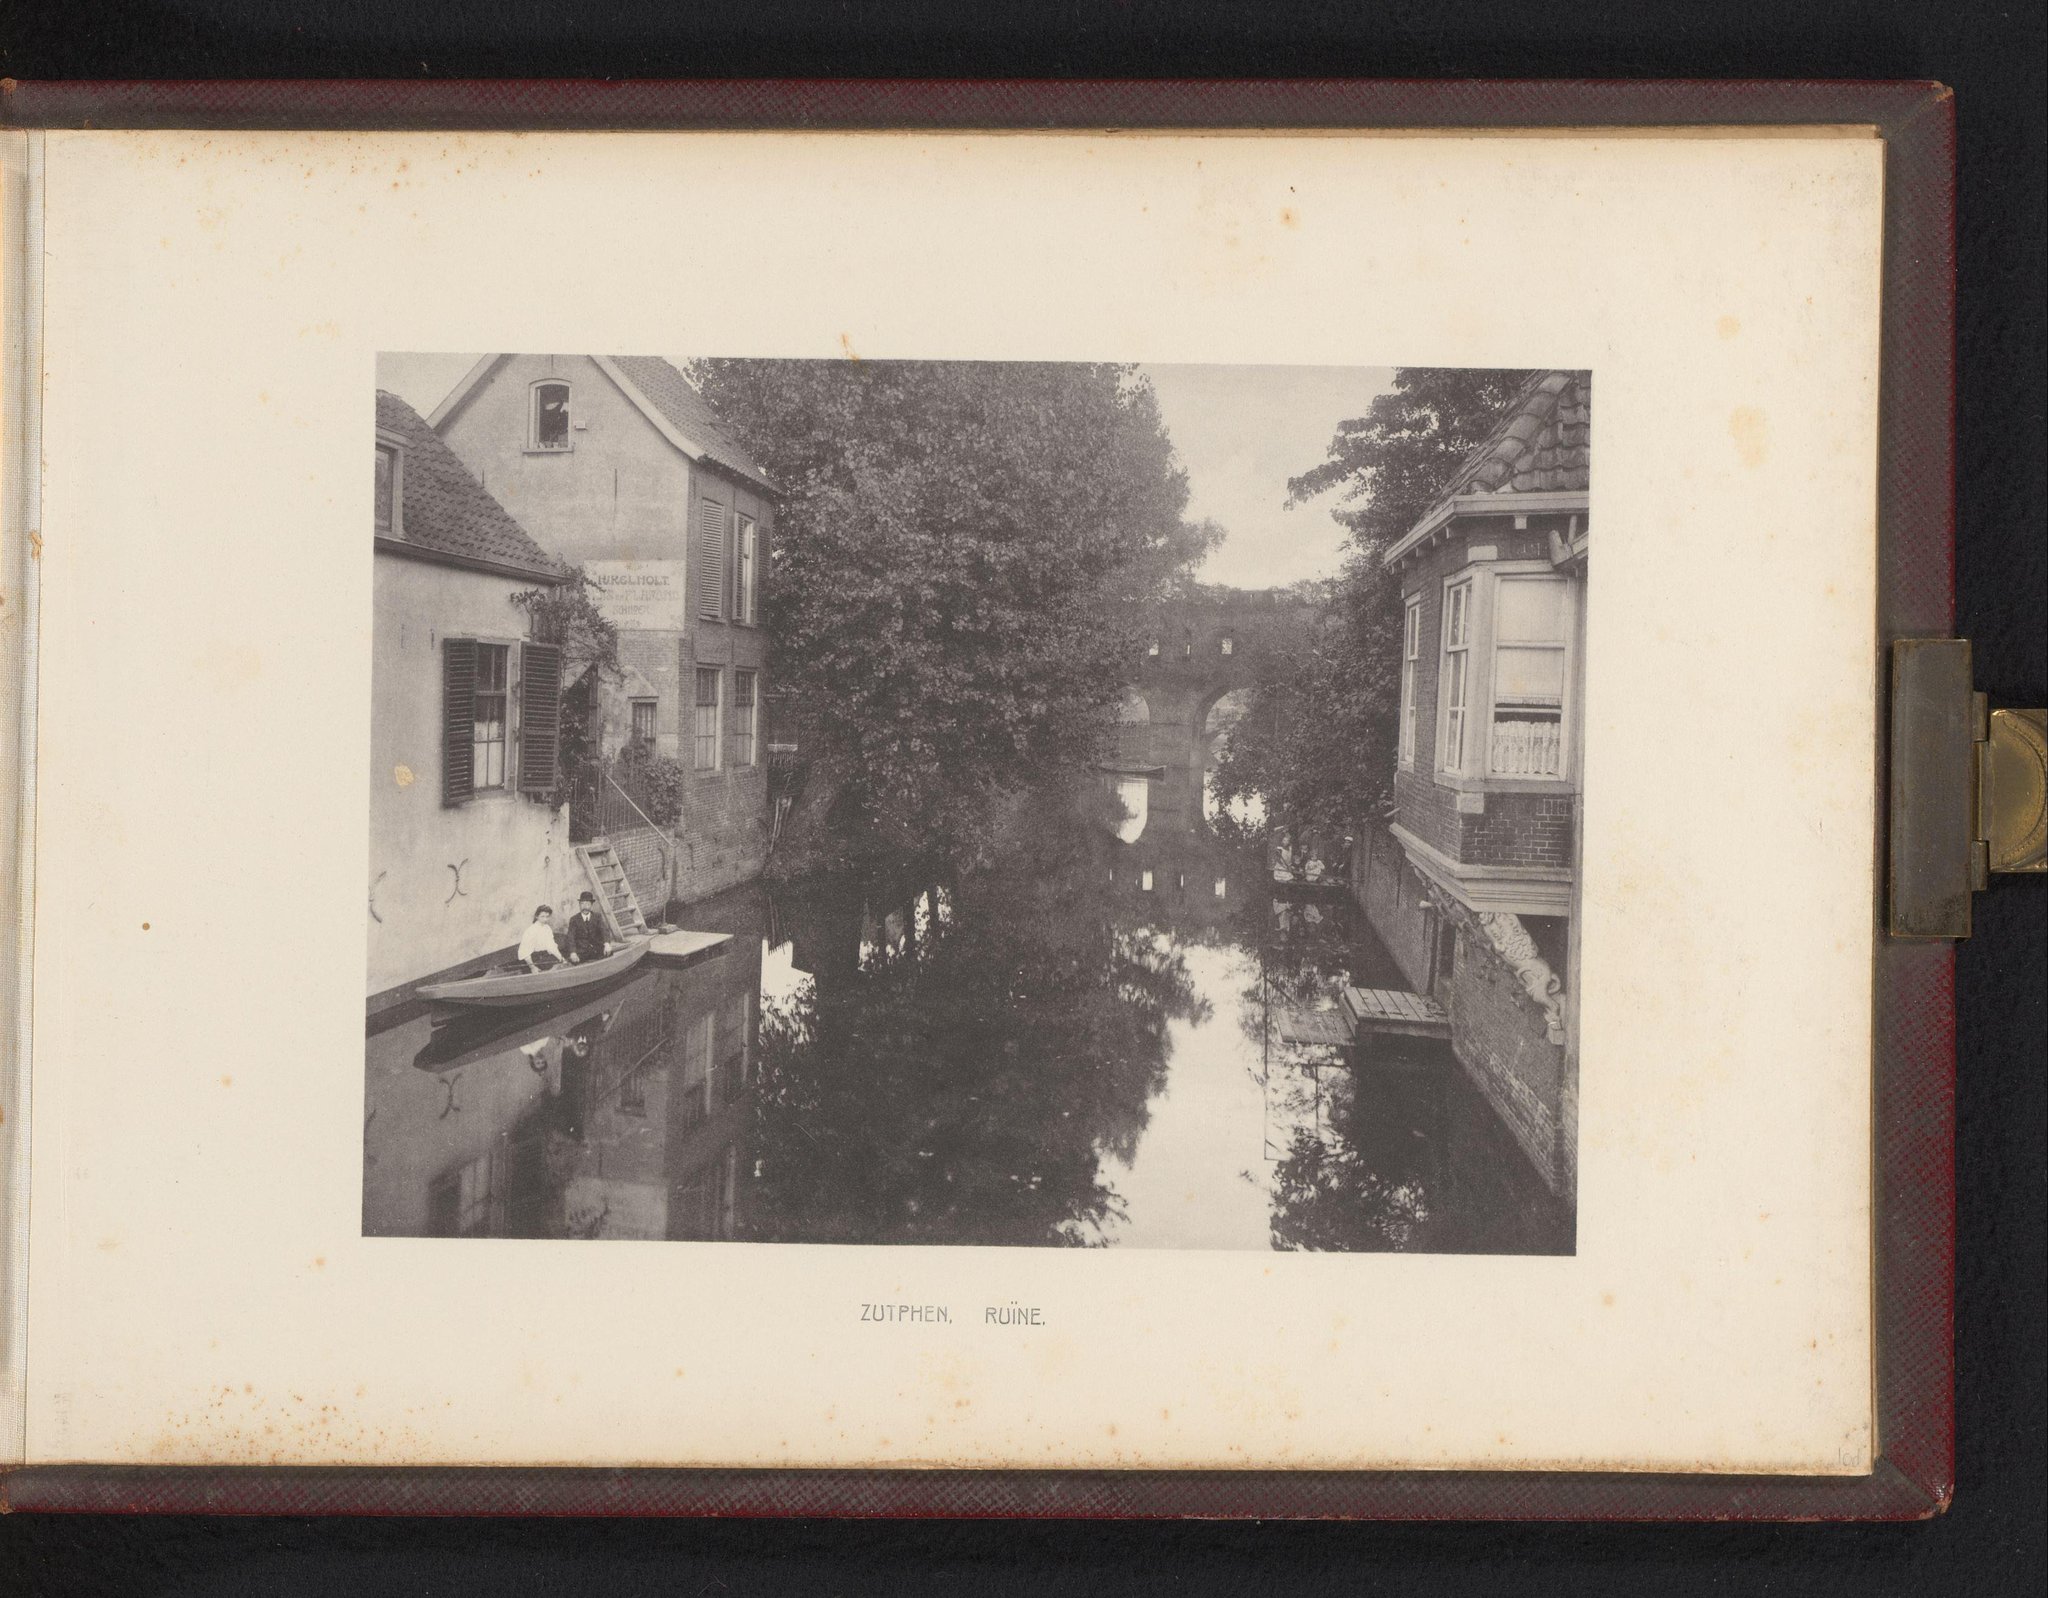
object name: album leaf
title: Gezicht op de ruïne van de Berkelpoort te Zutphen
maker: Anonymous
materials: paper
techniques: photograph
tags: gate ~ fortified city, rowing-boat, canoe, etc., canals, waters (in city), civic architecture; edifices; dwellings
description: Deze pagina maakt deel uit van een album.